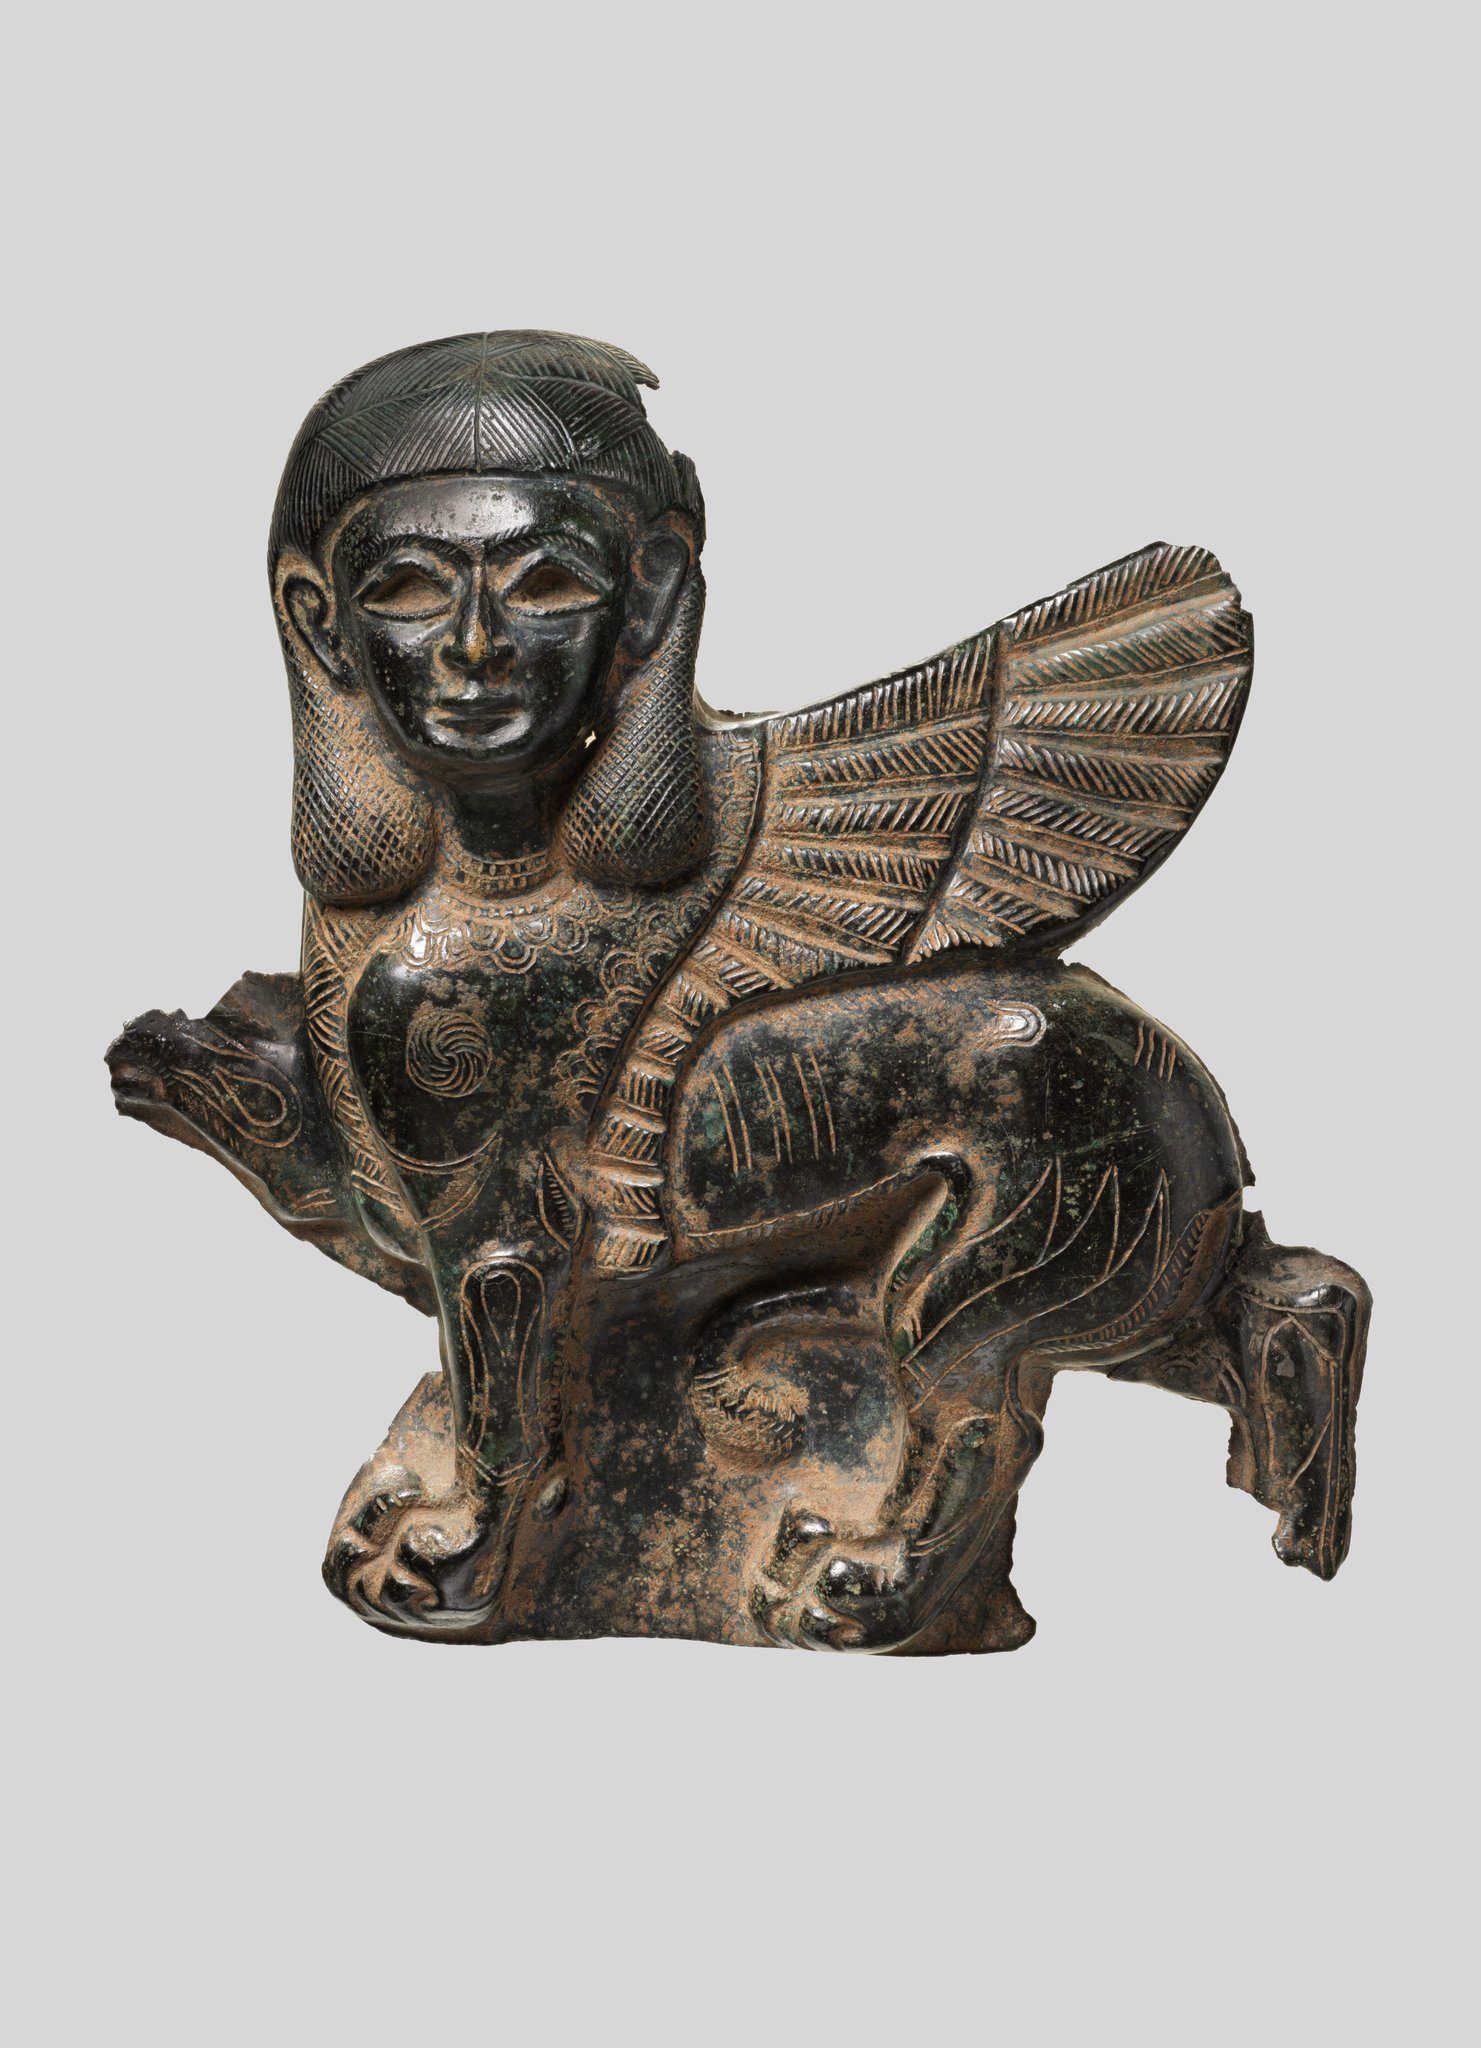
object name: relief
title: Plaque in the form of a sphinx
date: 800-701 BCE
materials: bronze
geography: syria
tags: sphinx